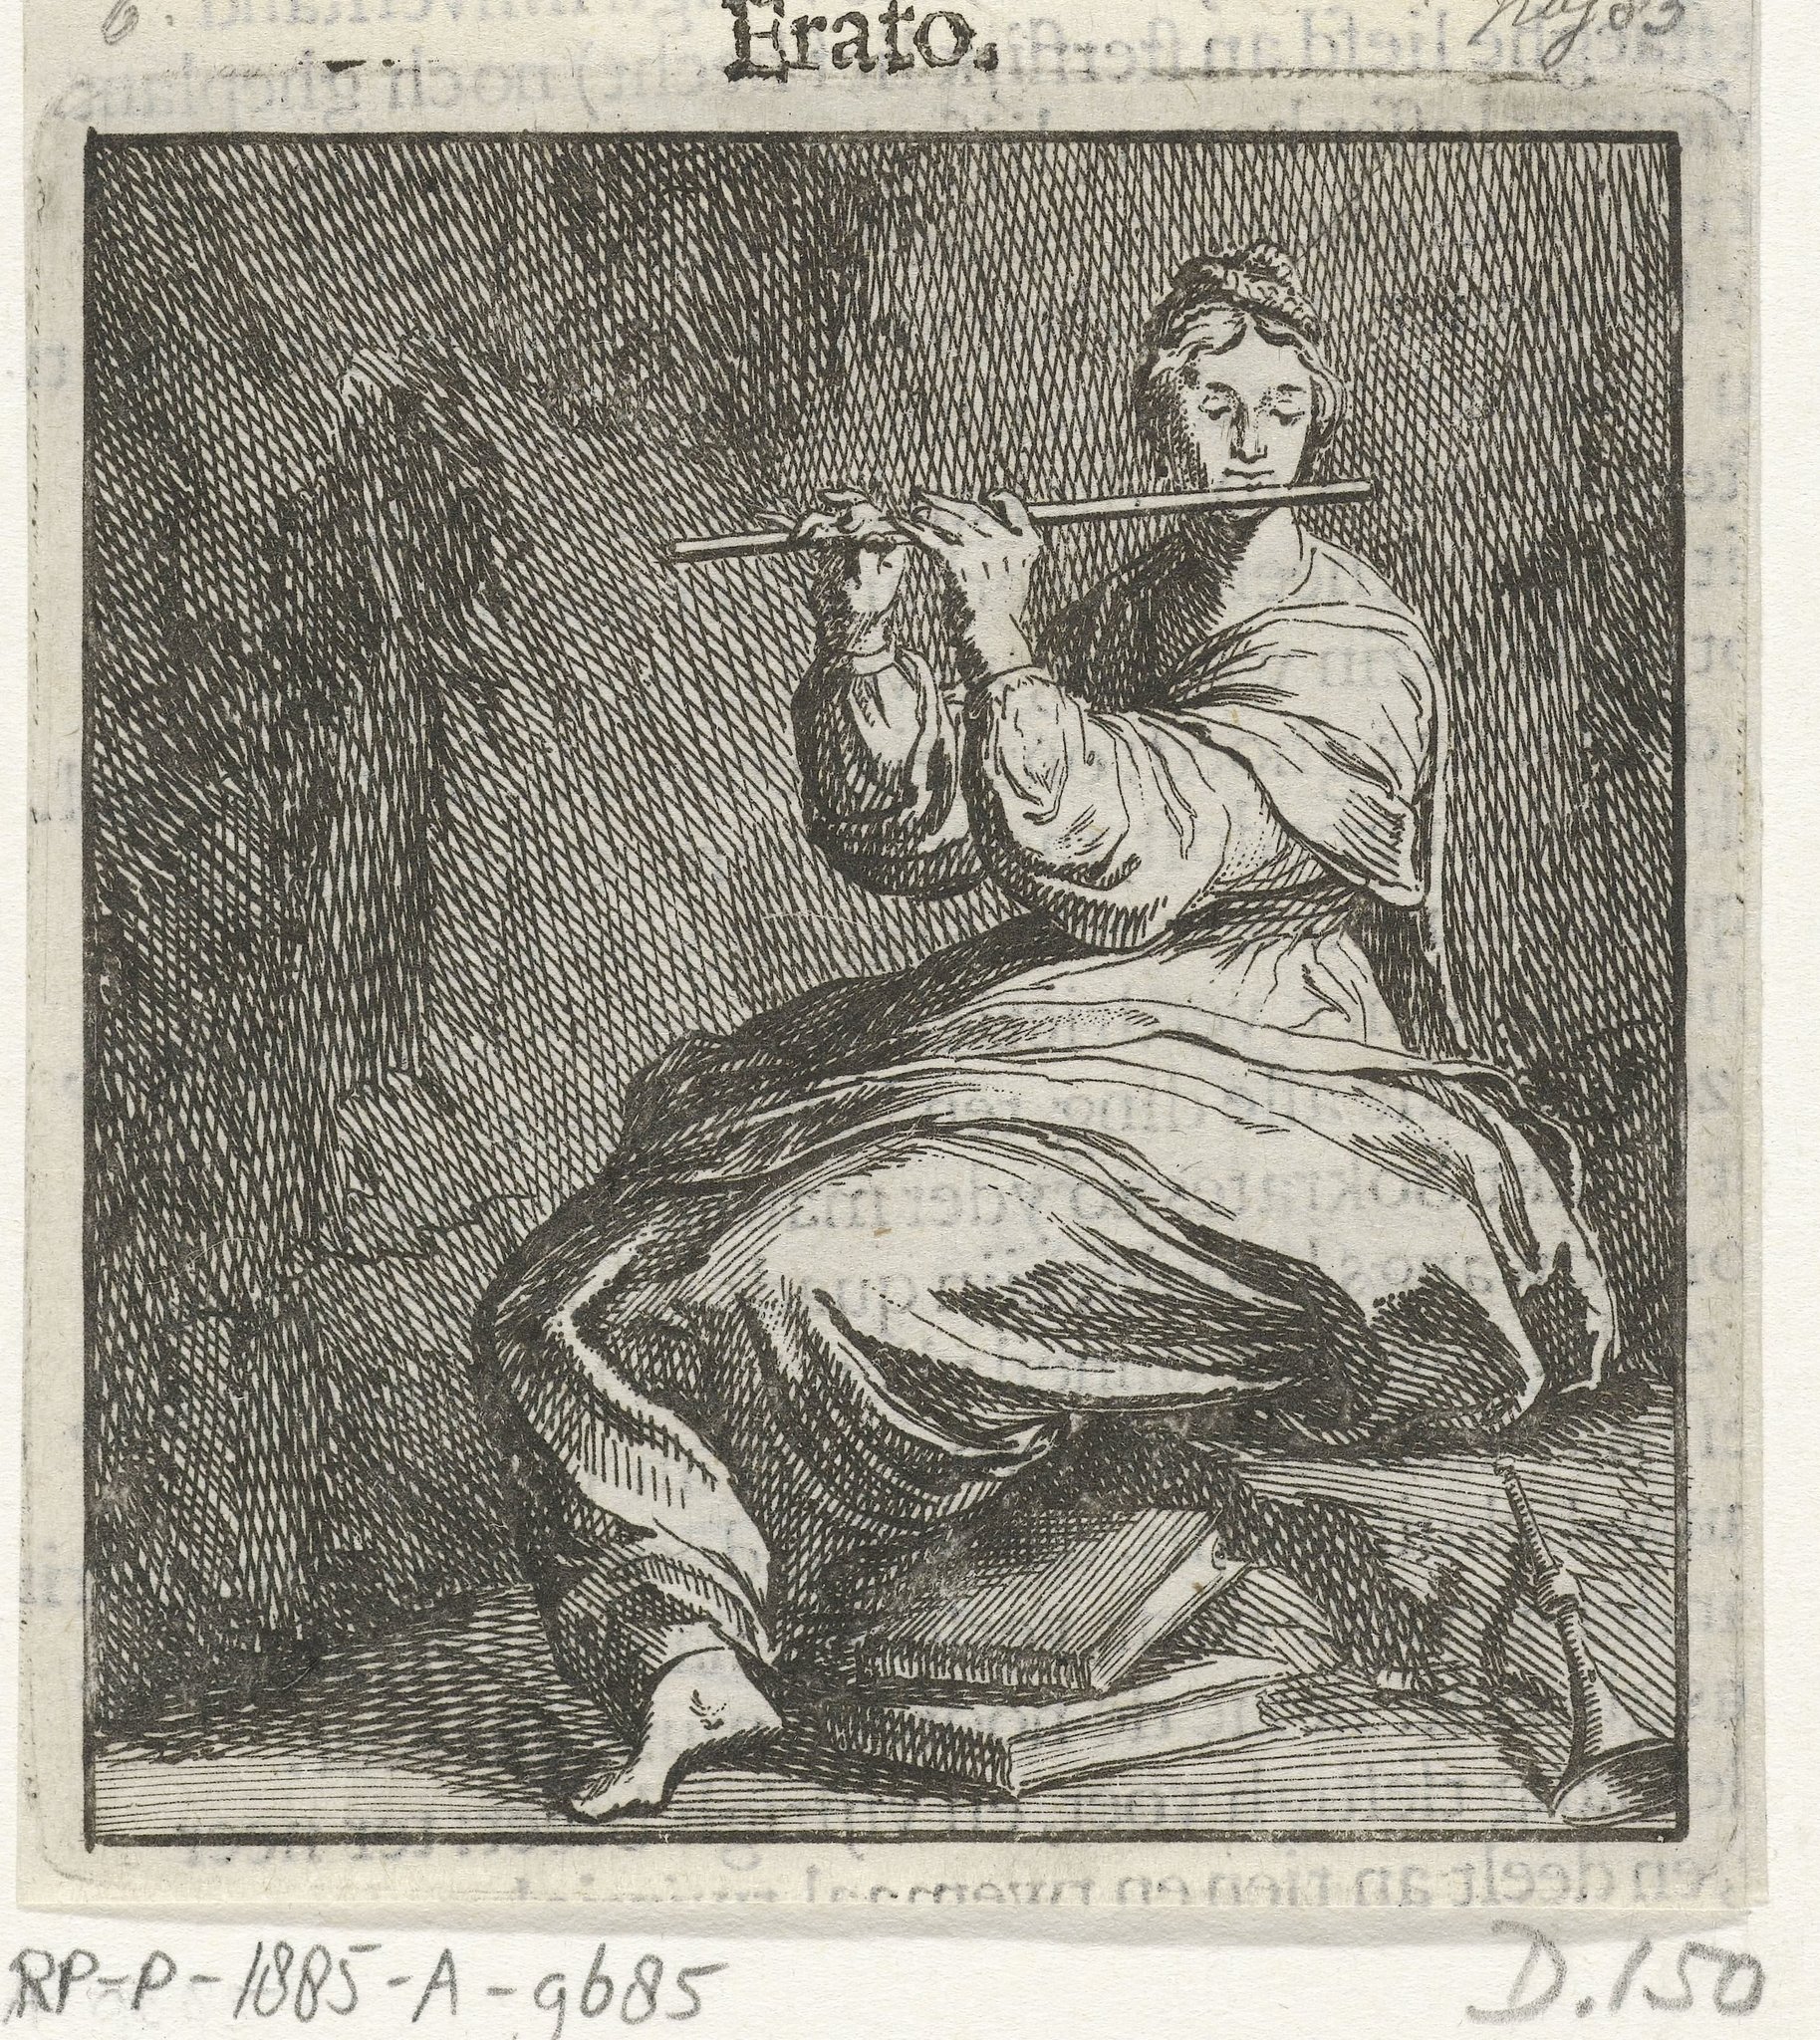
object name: print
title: Euterpe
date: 1650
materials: paper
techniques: engraving, etching, letterpress printing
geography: amsterdam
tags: euterpe (one of the muses); 'euterpe' (ripa)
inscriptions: inscription: ‘6 / pag 83’, collector's mark: Lugt 2228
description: Euterpe, de muze van de muziek en lyriek is hier abusievelijk aangeduid als Erato, de muze van de lyriek en liefdespoëzie. De zittende Euterpe bespeelt de dwarsfluit en aan haar voeten liggen een schalmei en boeken. Boekillustratie voor een boek waarin de verschillende muzen aan het woord komen.